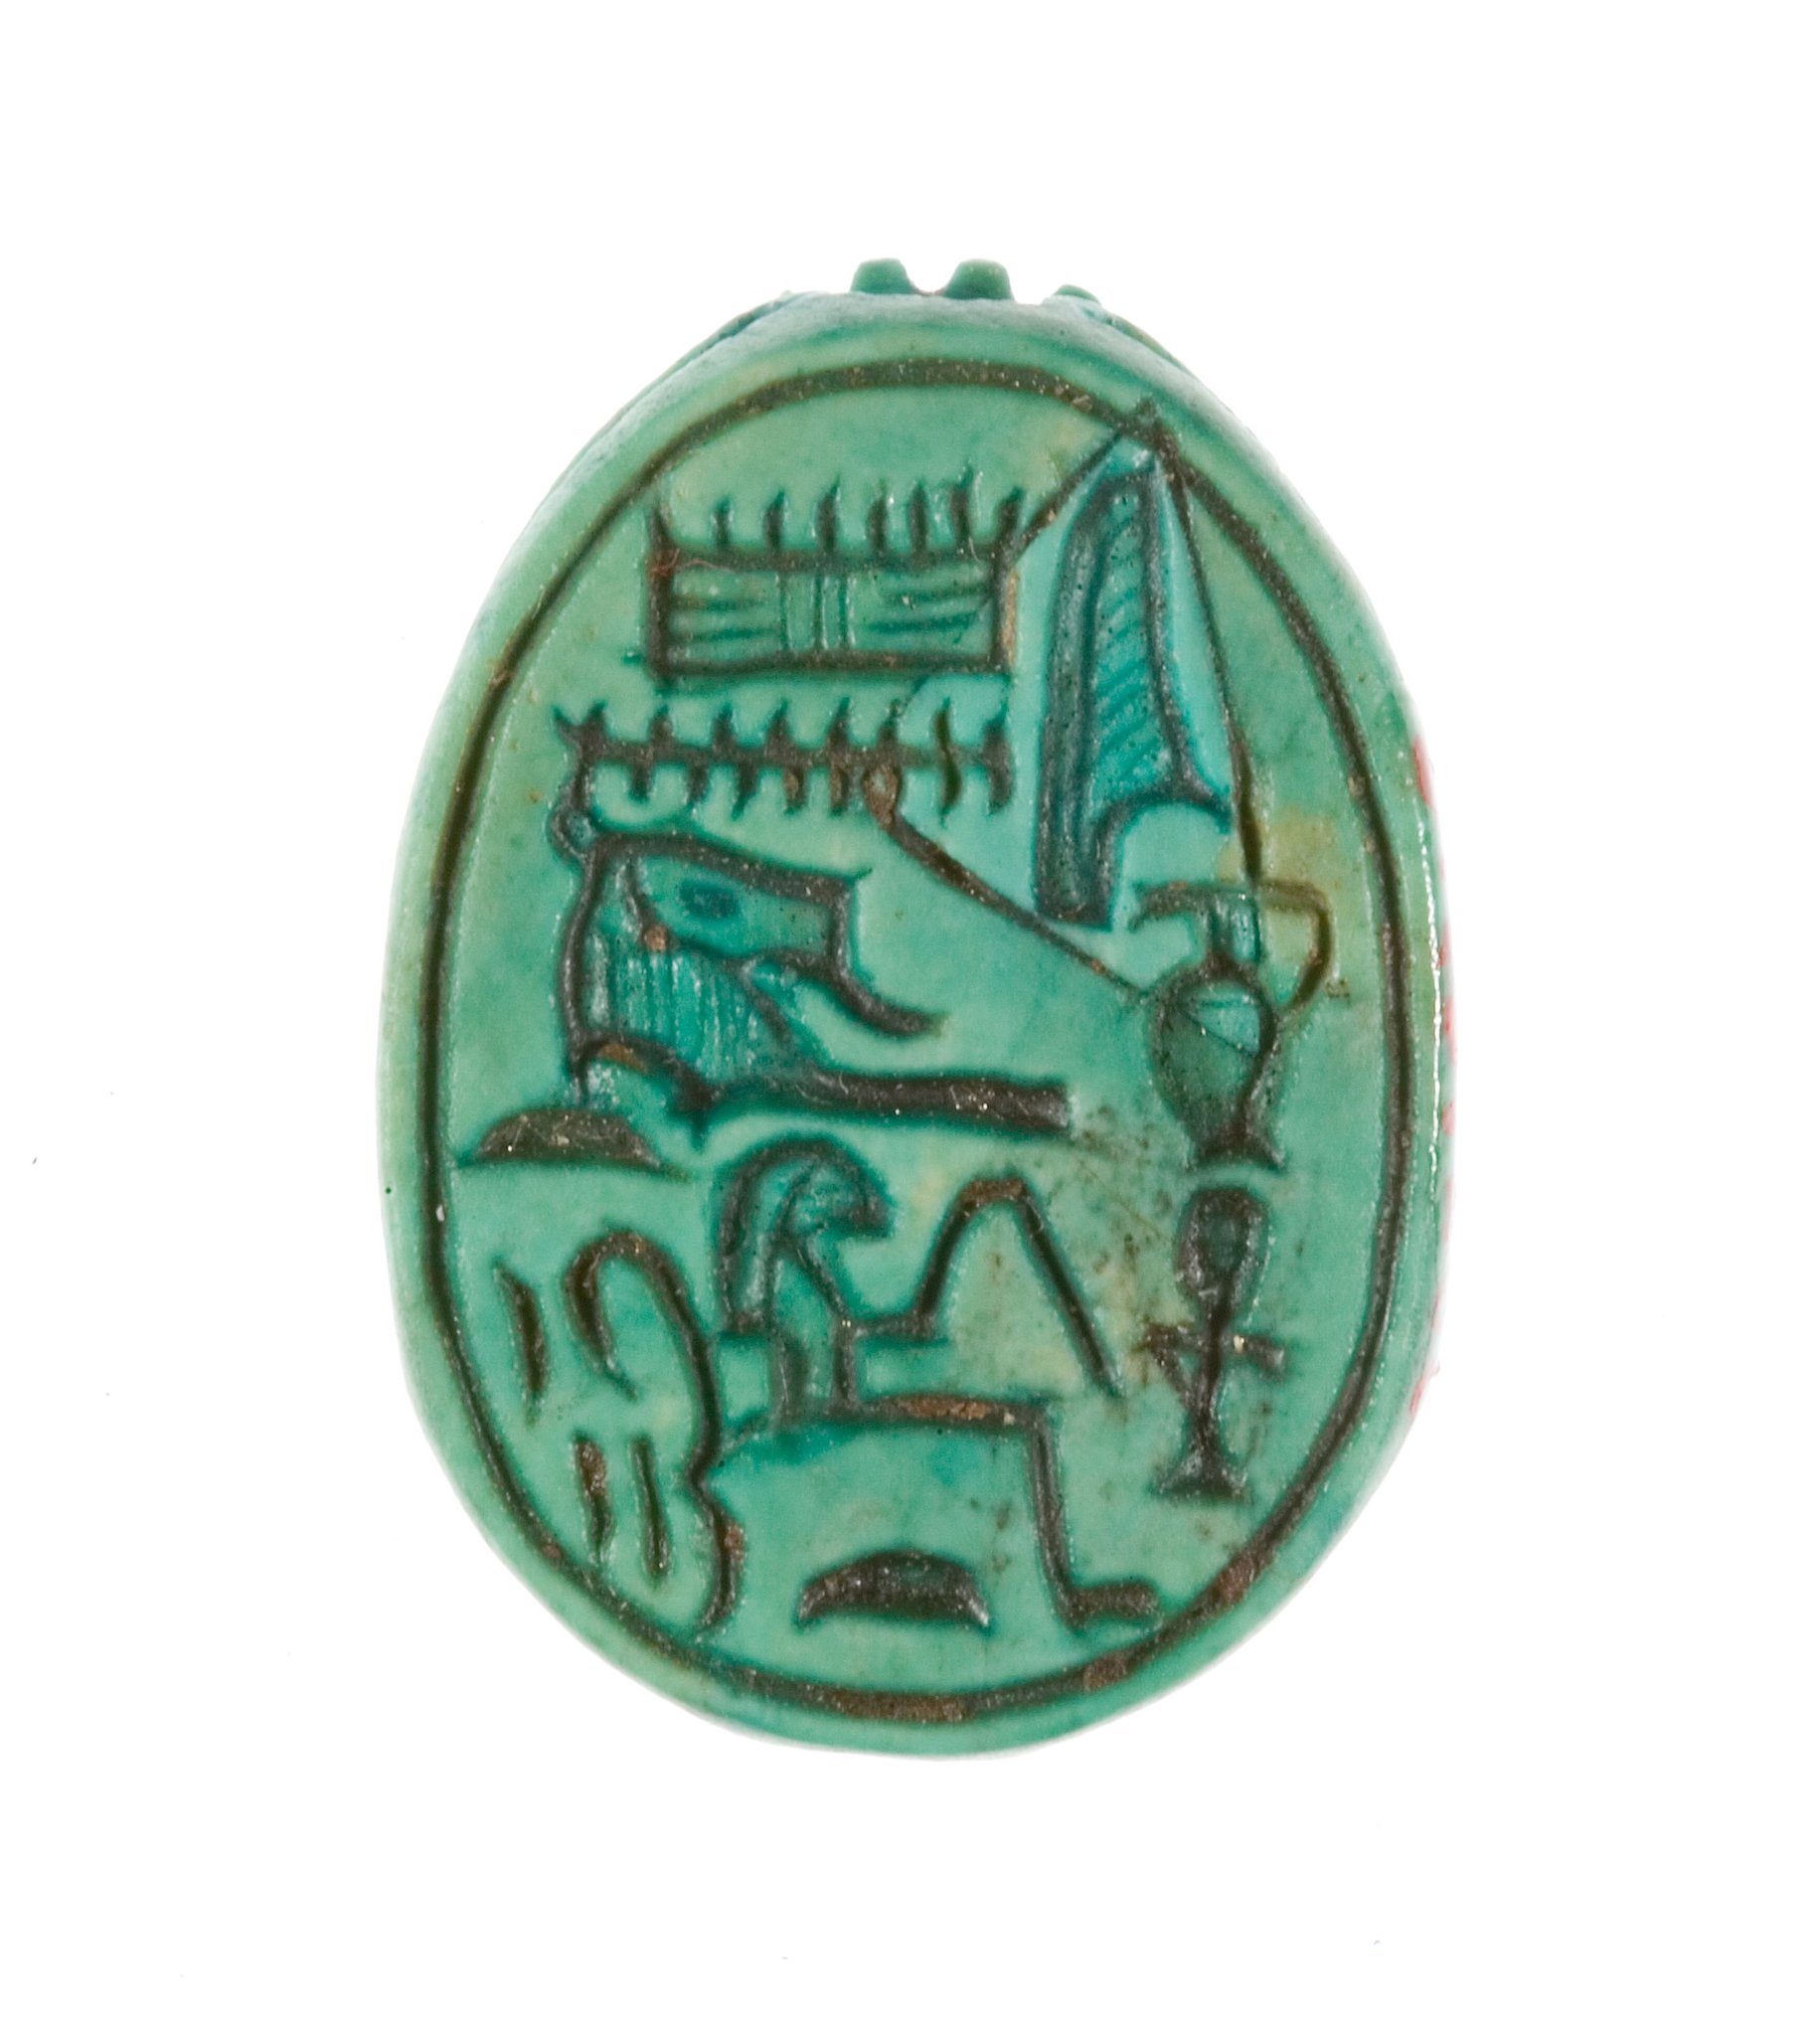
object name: scarab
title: Scarab Inscribed "Hatshepsut, United with Amun"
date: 1479-1458 BCE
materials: stone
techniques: glazing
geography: egypt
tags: amun,scarabs